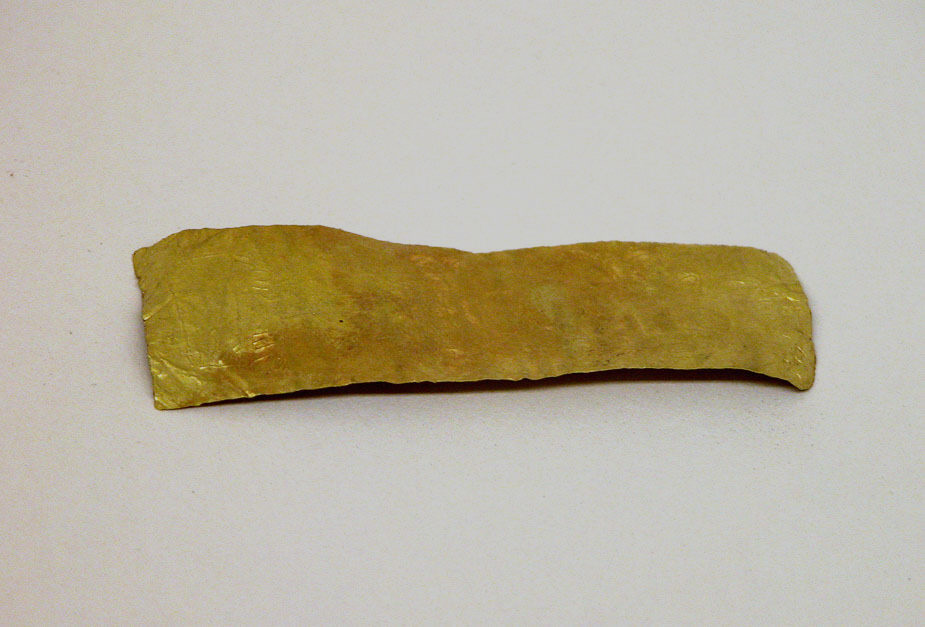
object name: gold foil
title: Gold Foil incised with Standing Image of Goddess Sri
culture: indonesian, javanese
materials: gold